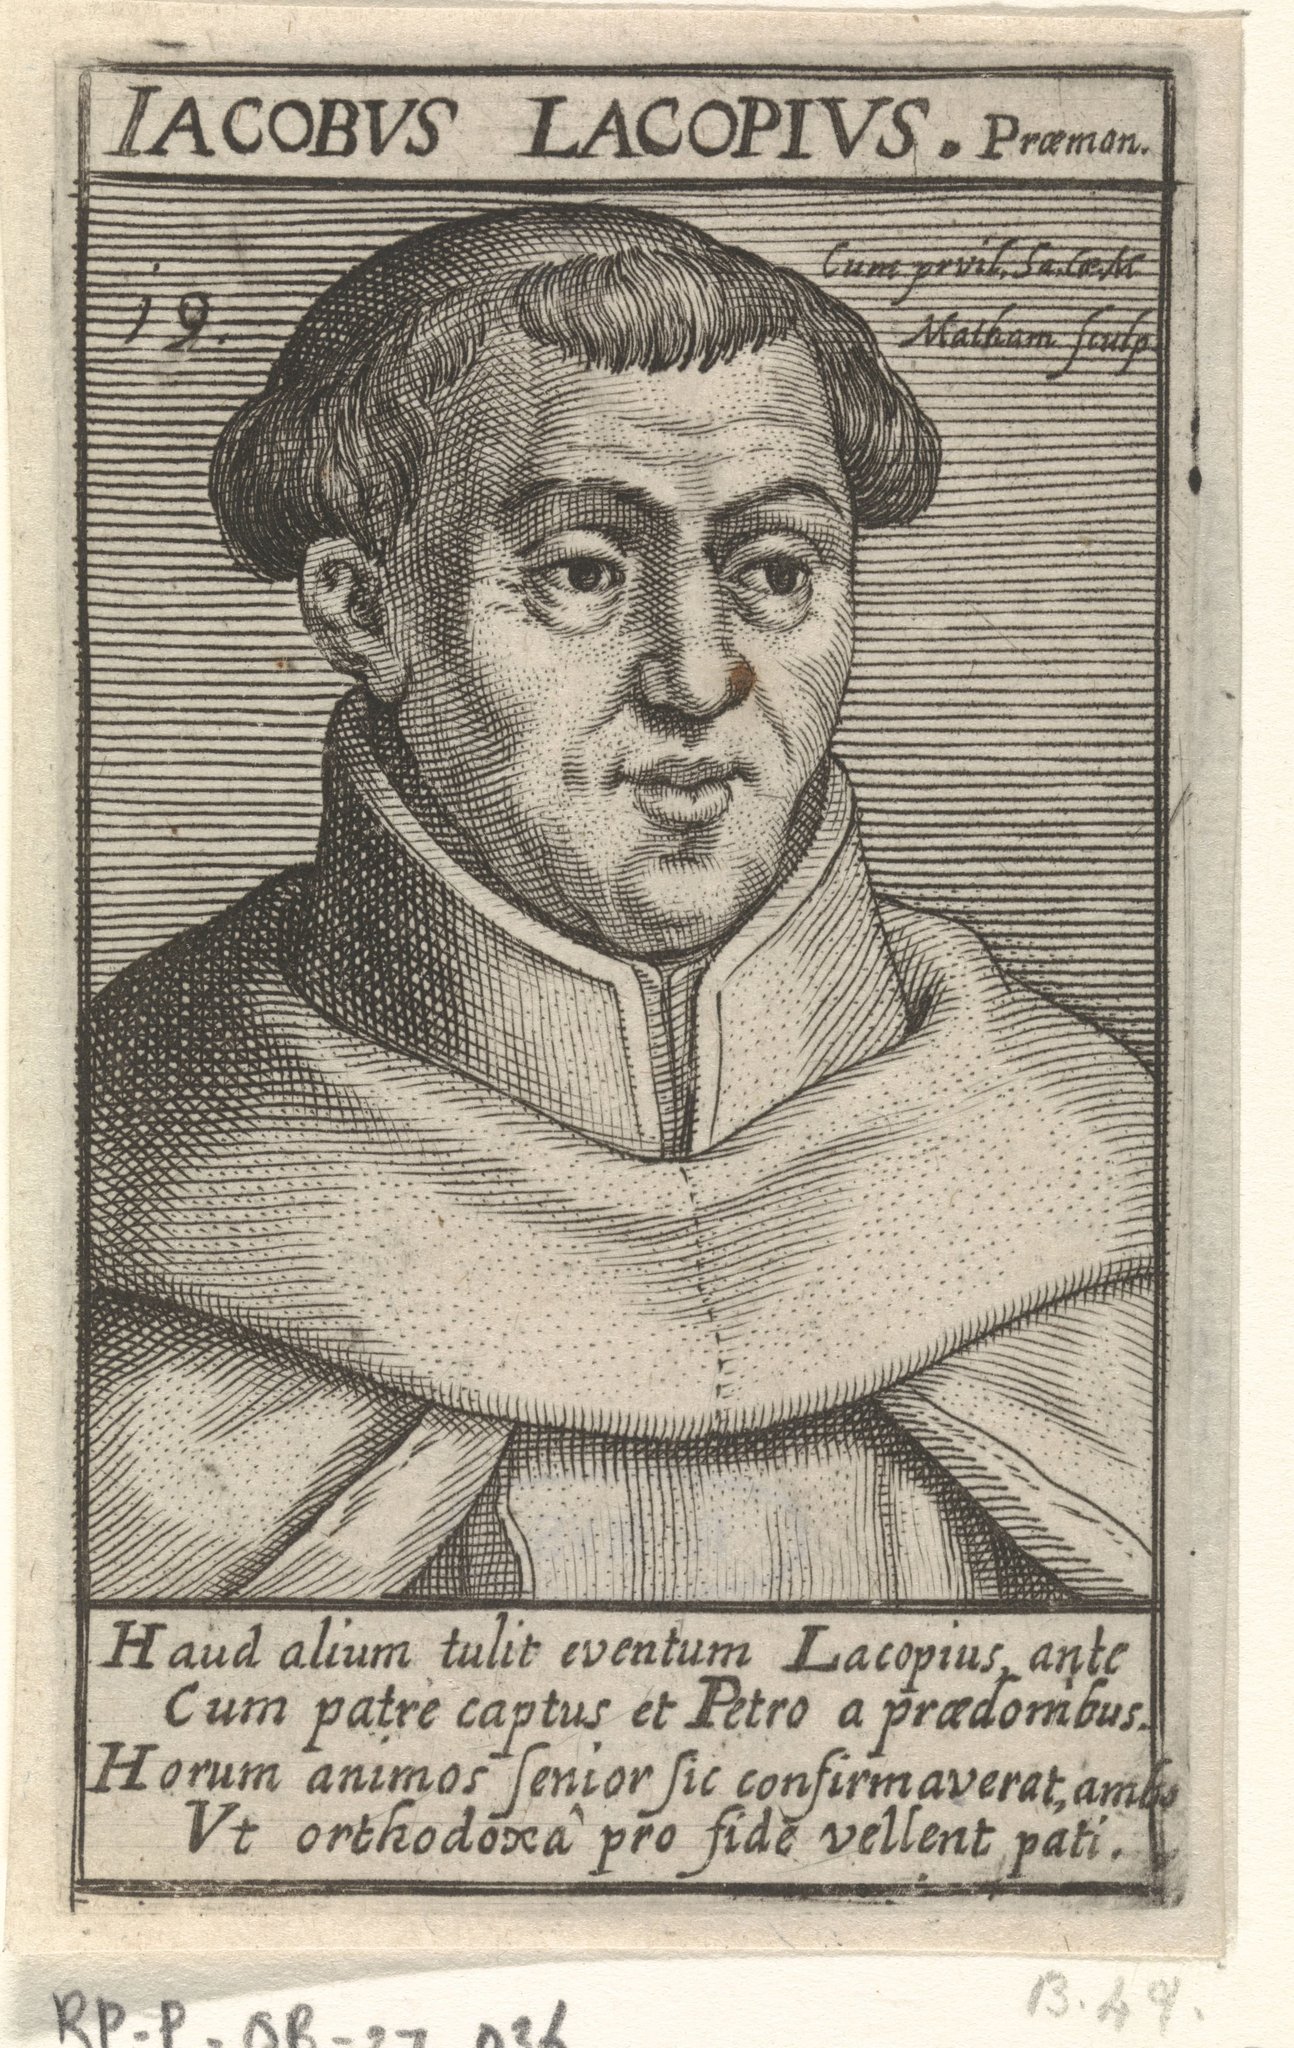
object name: print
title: Martelaren van Gorcum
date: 1617-1618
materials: paper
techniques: engraving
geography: haarlem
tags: brielle, martyrs of gorkum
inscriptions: collector's mark: Lugt 2228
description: Portret van de heilige Jacobus Lacopus, een van de negentien katholieke martelaren van Gorinchem.